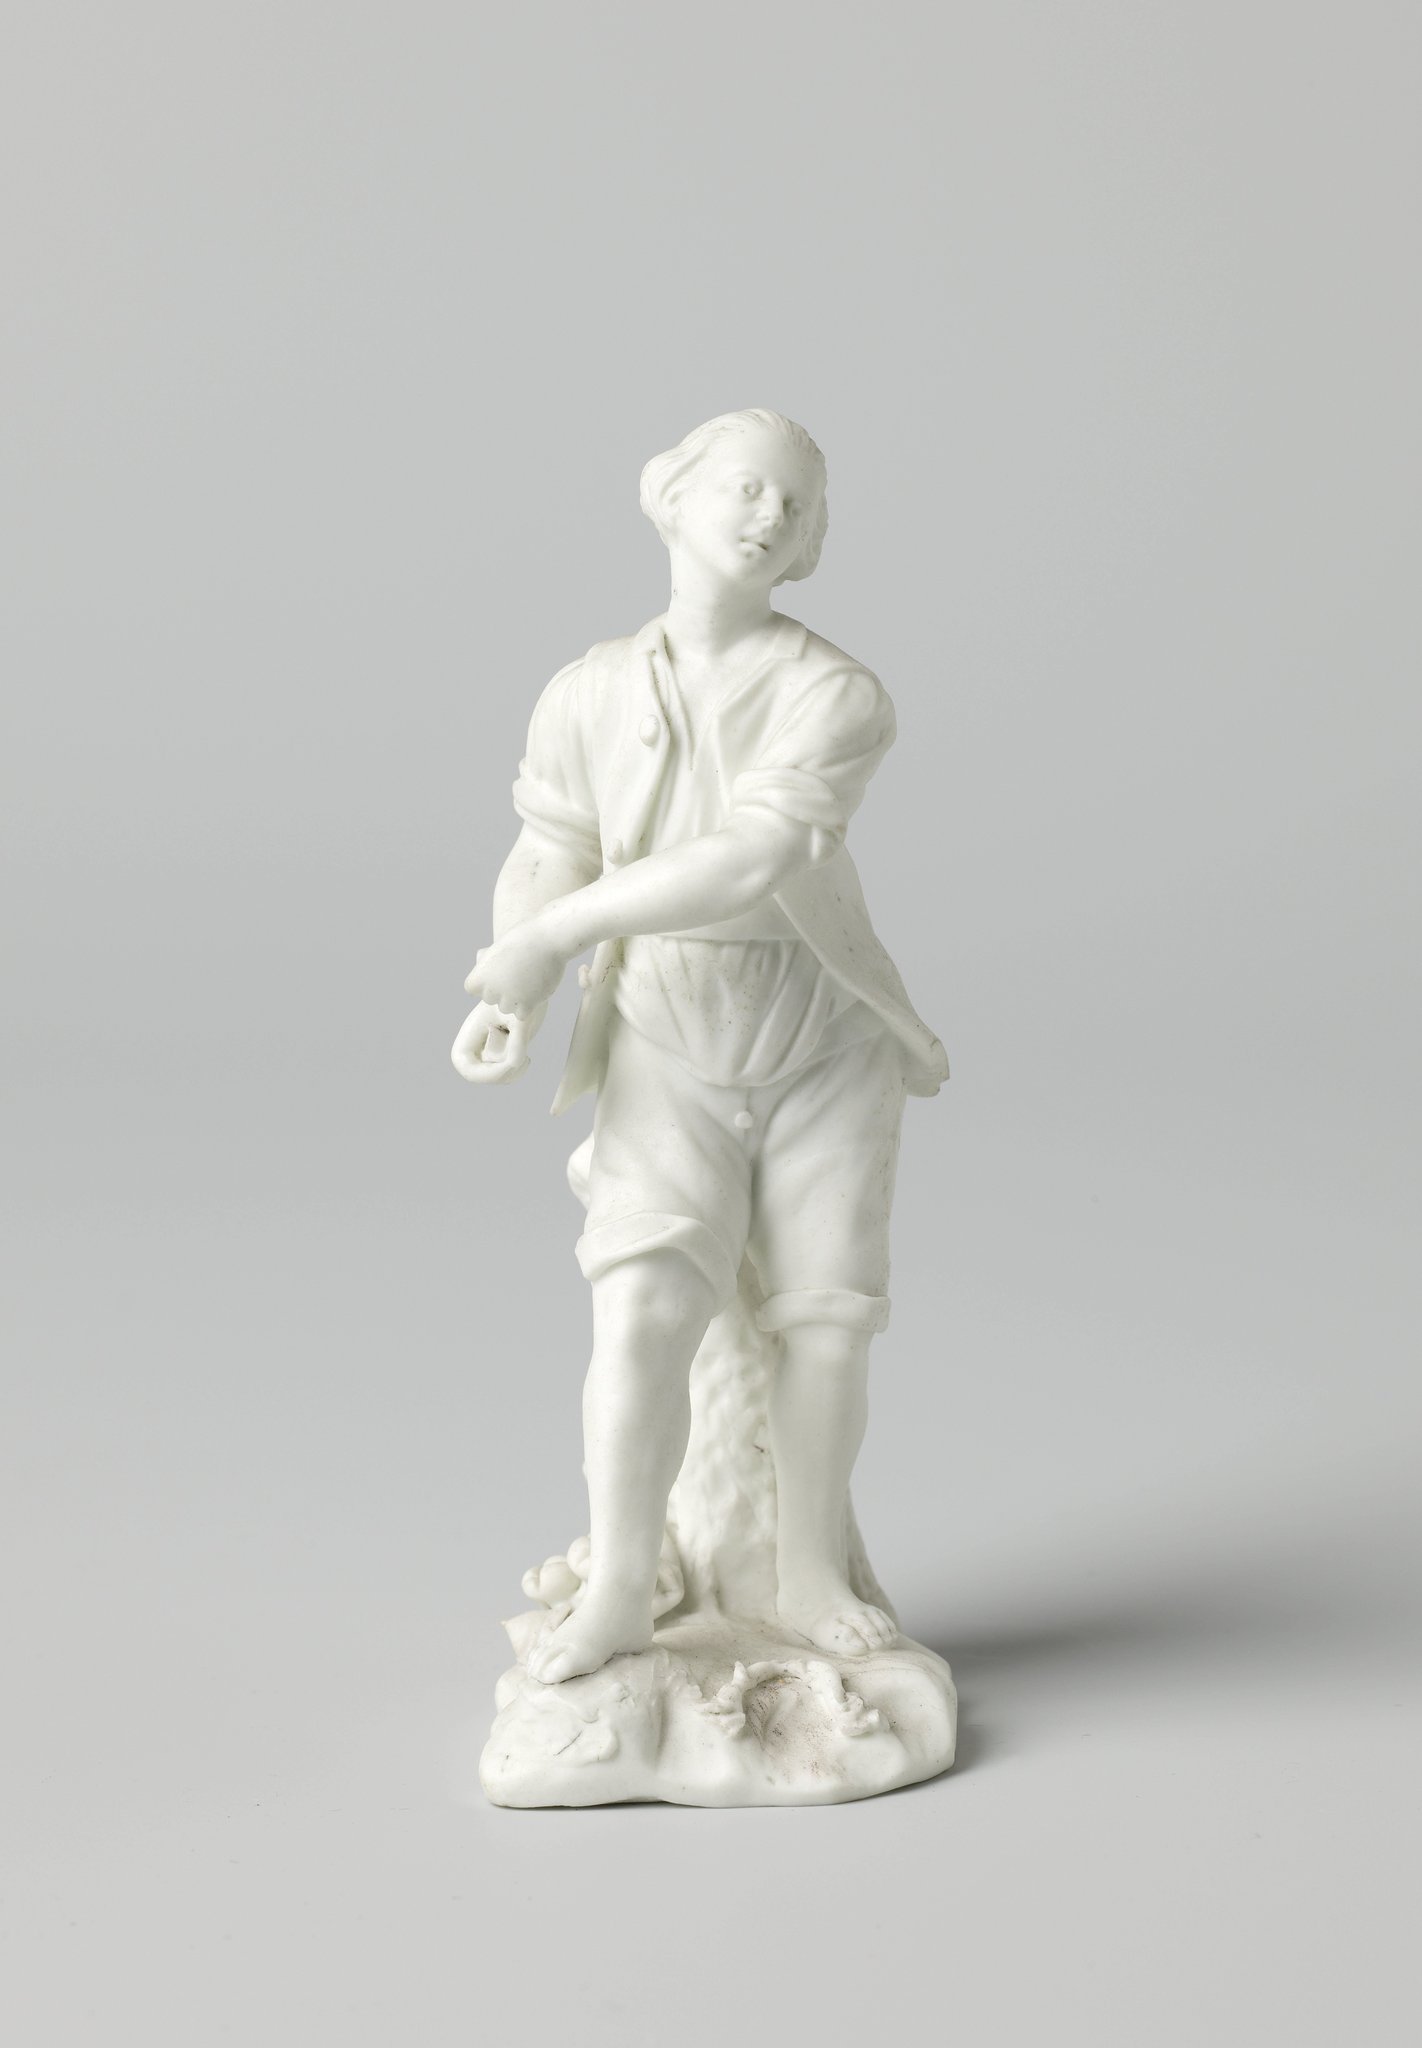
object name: figure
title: Figuur van een herder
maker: Anonymous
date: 1600-1950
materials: earthenware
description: Beeldhouwwerk, figuur van een herder van wit ongeglazuurd porselein, z.g. biscuit.